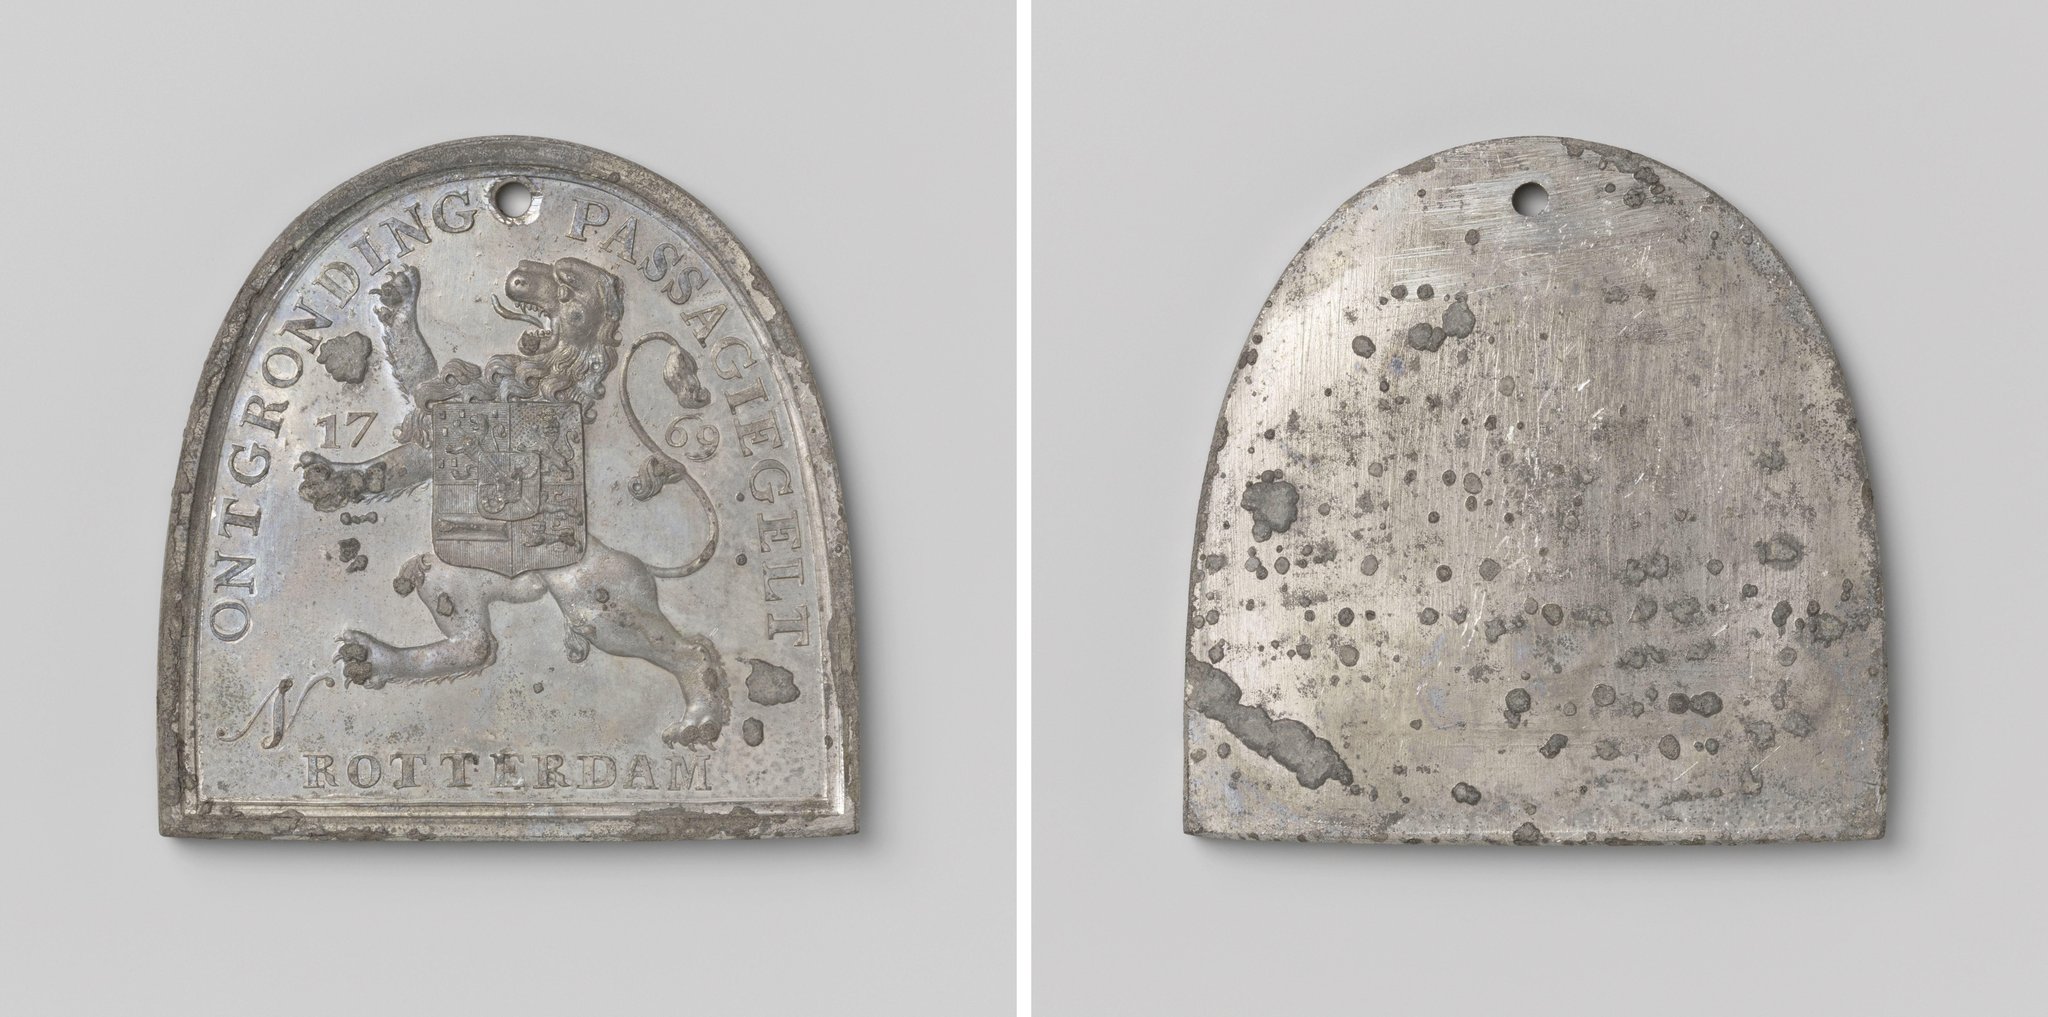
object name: identification medal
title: Ontgronding te Rotterdam, penning bedoeld als bewijs voor turfdragers, -vullers of -tonners om turf in te mogen voeren uit de nieuw ontgronde venen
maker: Anonymous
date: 1769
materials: lead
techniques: casting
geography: rotterdam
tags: rotterdam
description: Eenzijdige loden penning met ronde boven- en rechthoekige onderzijde, en gat erin. Voorzijde: staande leeuw met wapenschild op borst tussen jaartal binnen omschrift. Keerzijde: blanco.